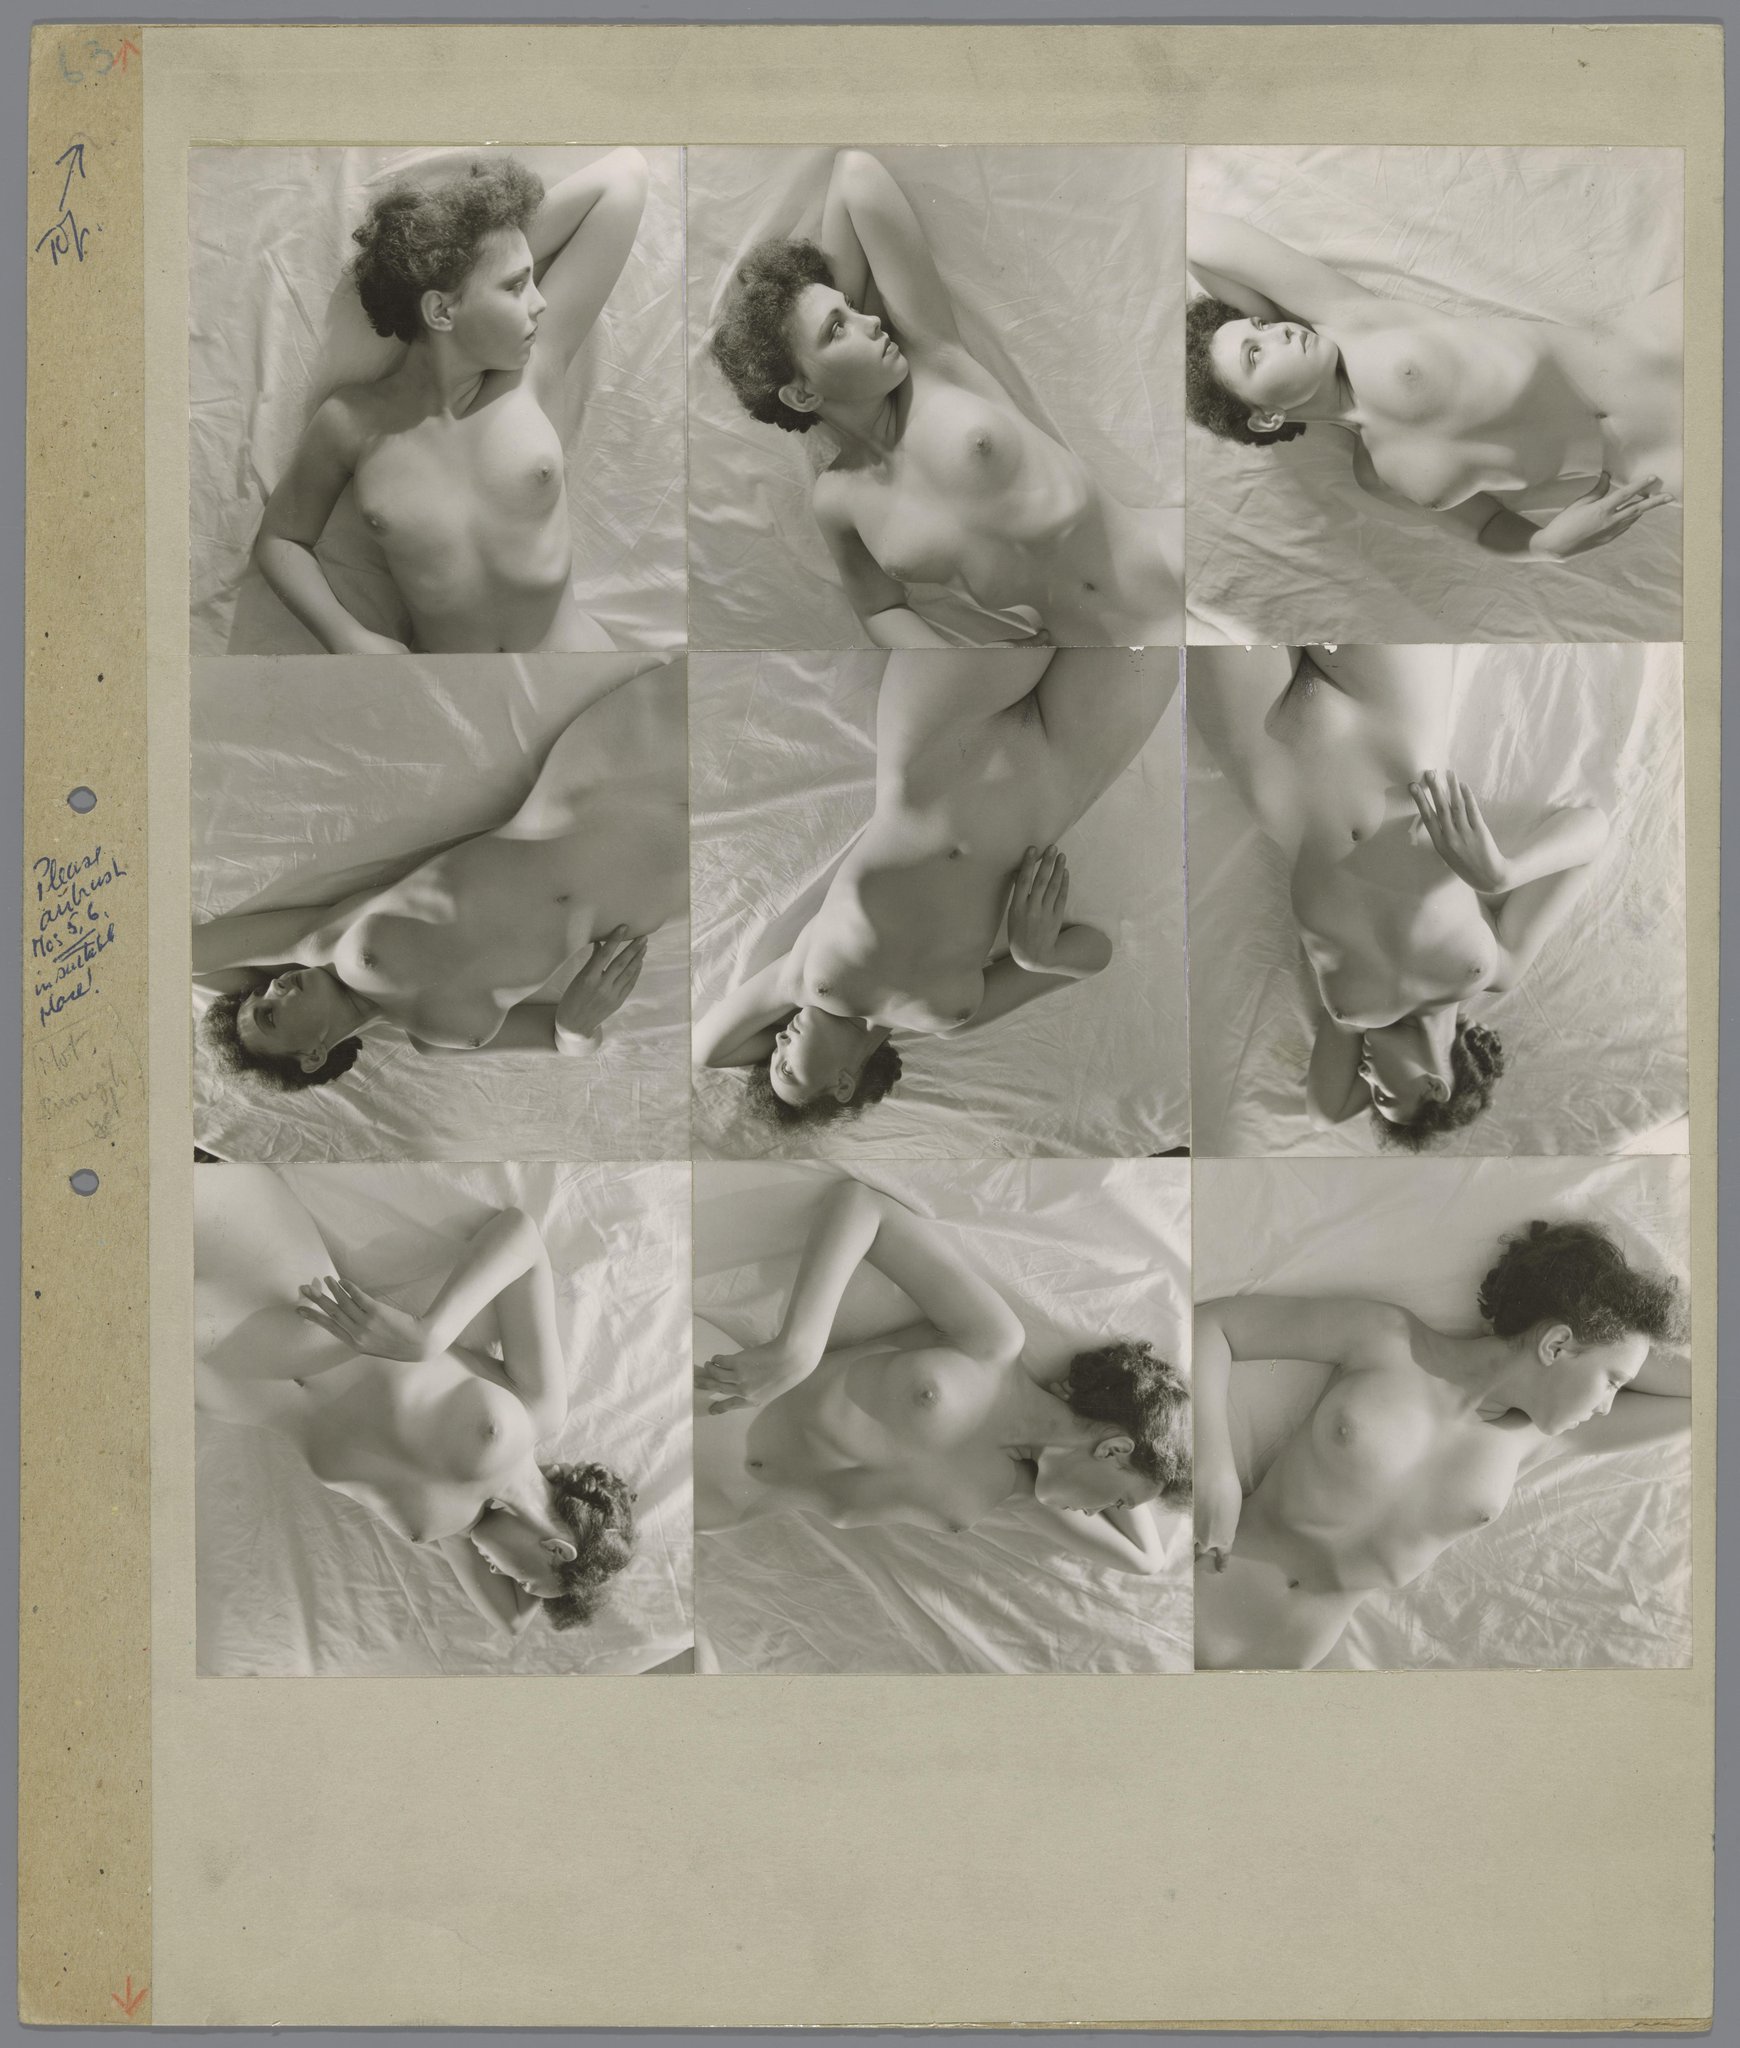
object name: photocollage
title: Negen portretten van naaktmodel Pamela Green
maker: john everard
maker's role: fotograaf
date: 1953-1954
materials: paper, cardboard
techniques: gelatin silver print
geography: england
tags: the (nude) human figure; 'corpo humano' (ripa) - aa - female human figure, england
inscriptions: inscription: ‘Not/ enough/ yet’, number: ‘10-64/ BY/H169’, inscription: ‘Please/ airbrush/ Nos 5,6,/ insuitable [?]/ more!’